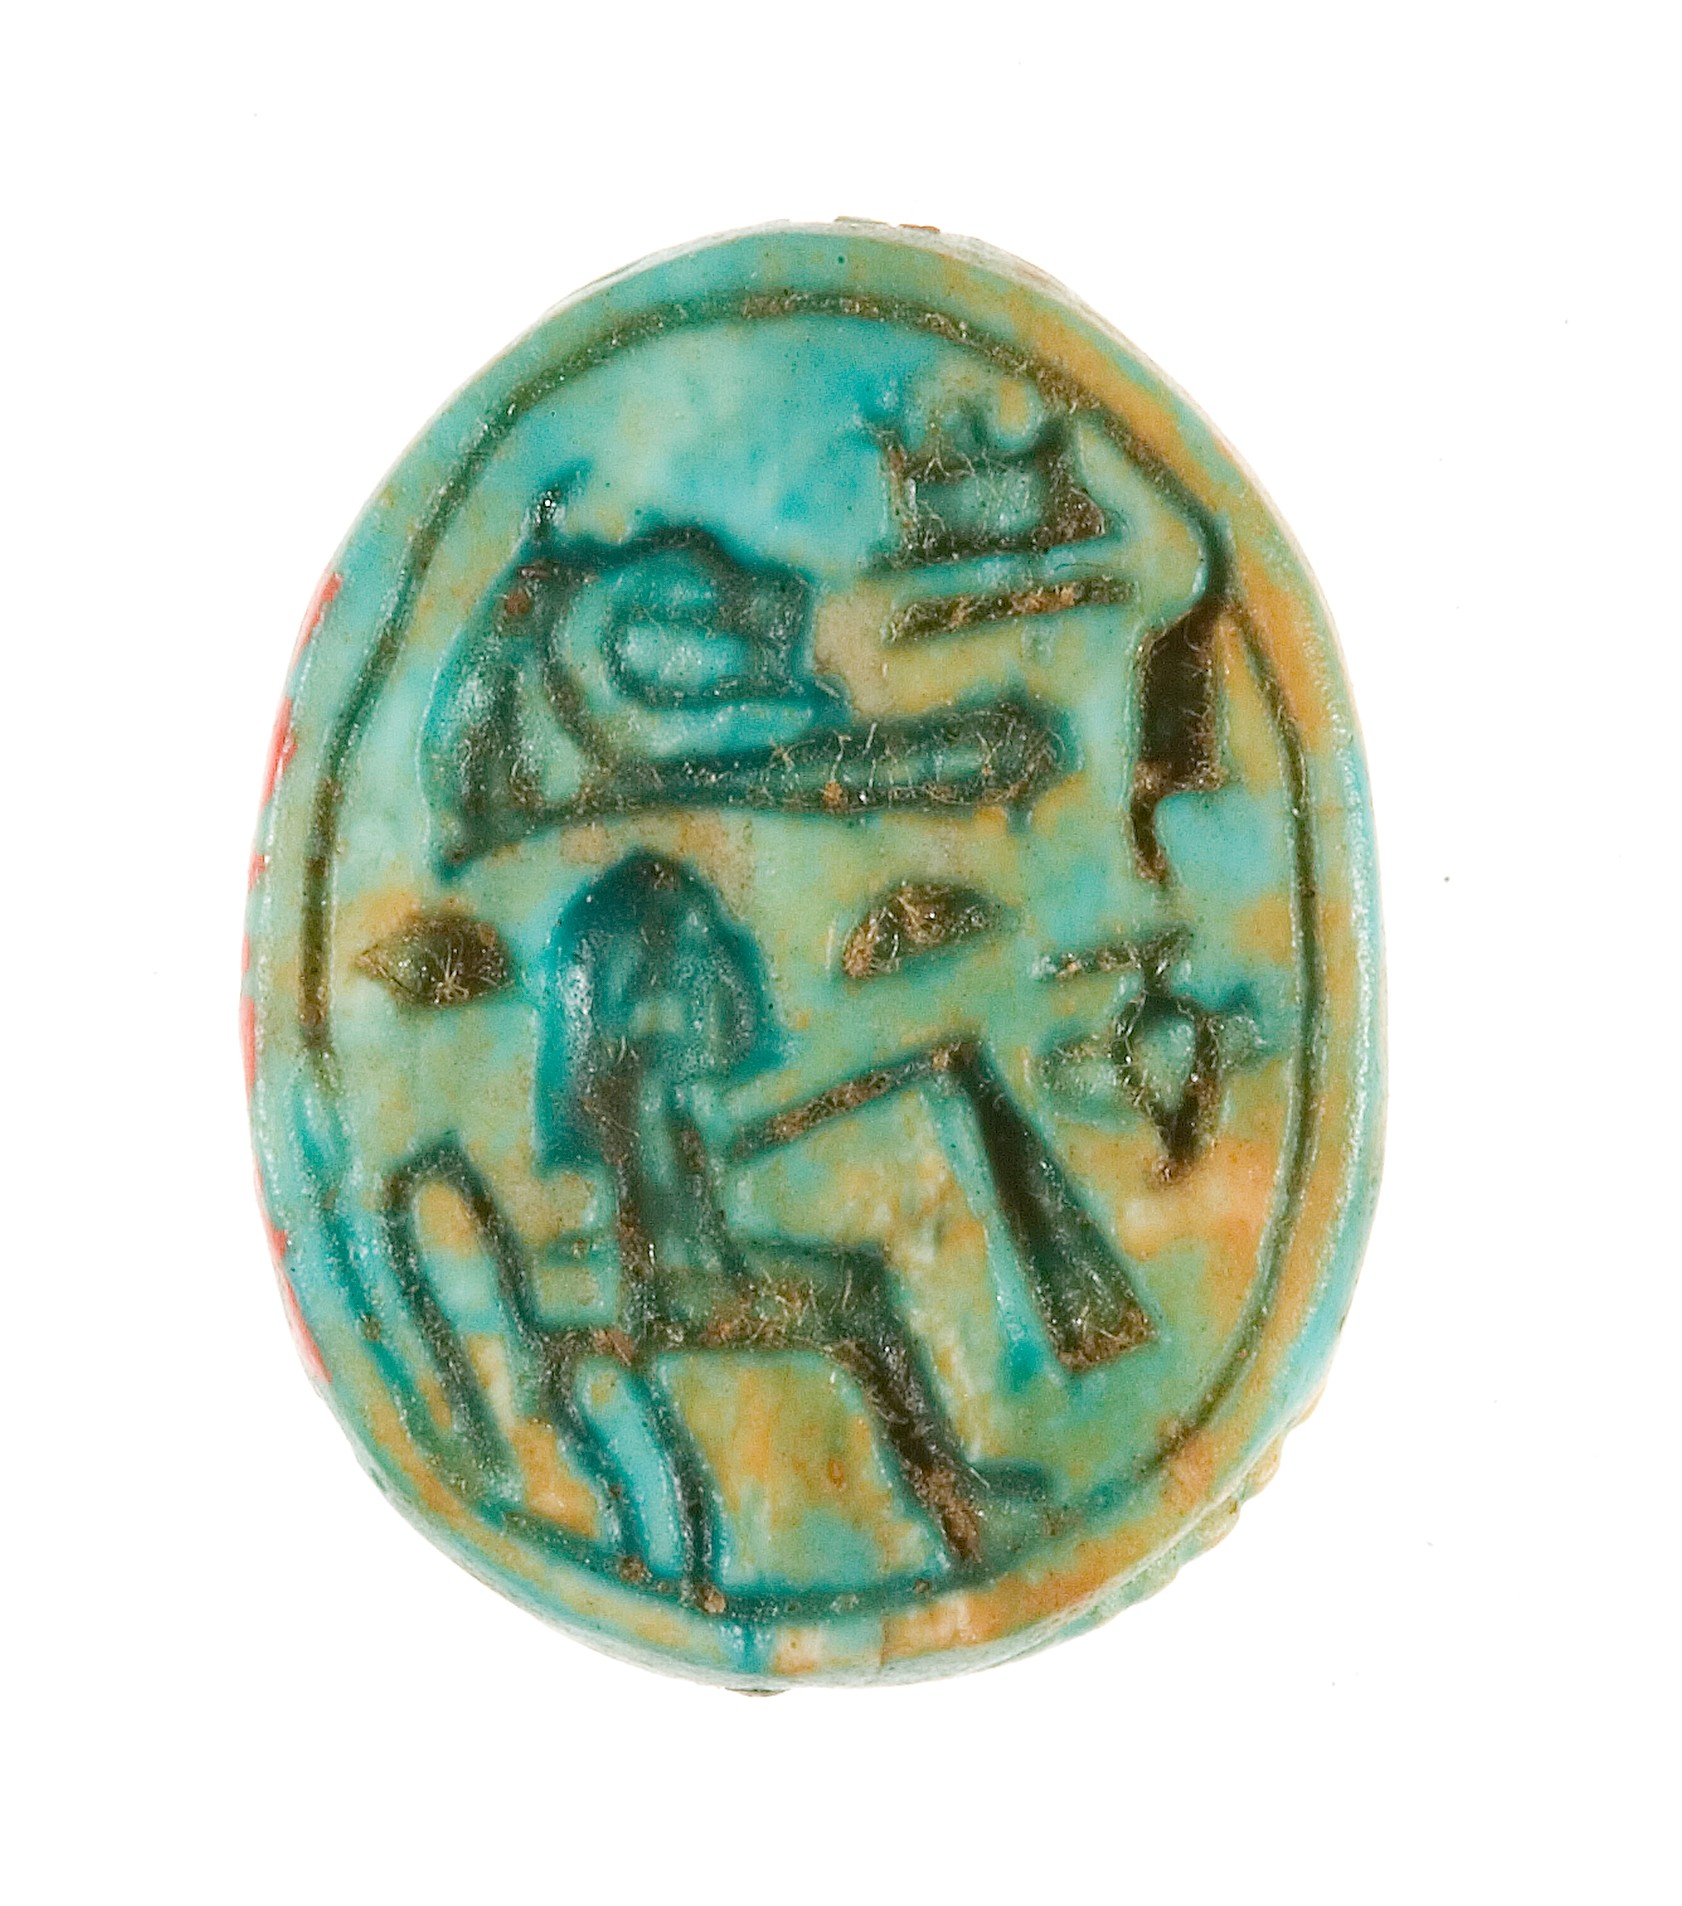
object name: scarab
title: Scarab Inscribed Hatshepsut-United-with-Amun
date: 1479-1458 BCE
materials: stone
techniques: glazing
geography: egypt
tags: hieroglyphs,scarabs